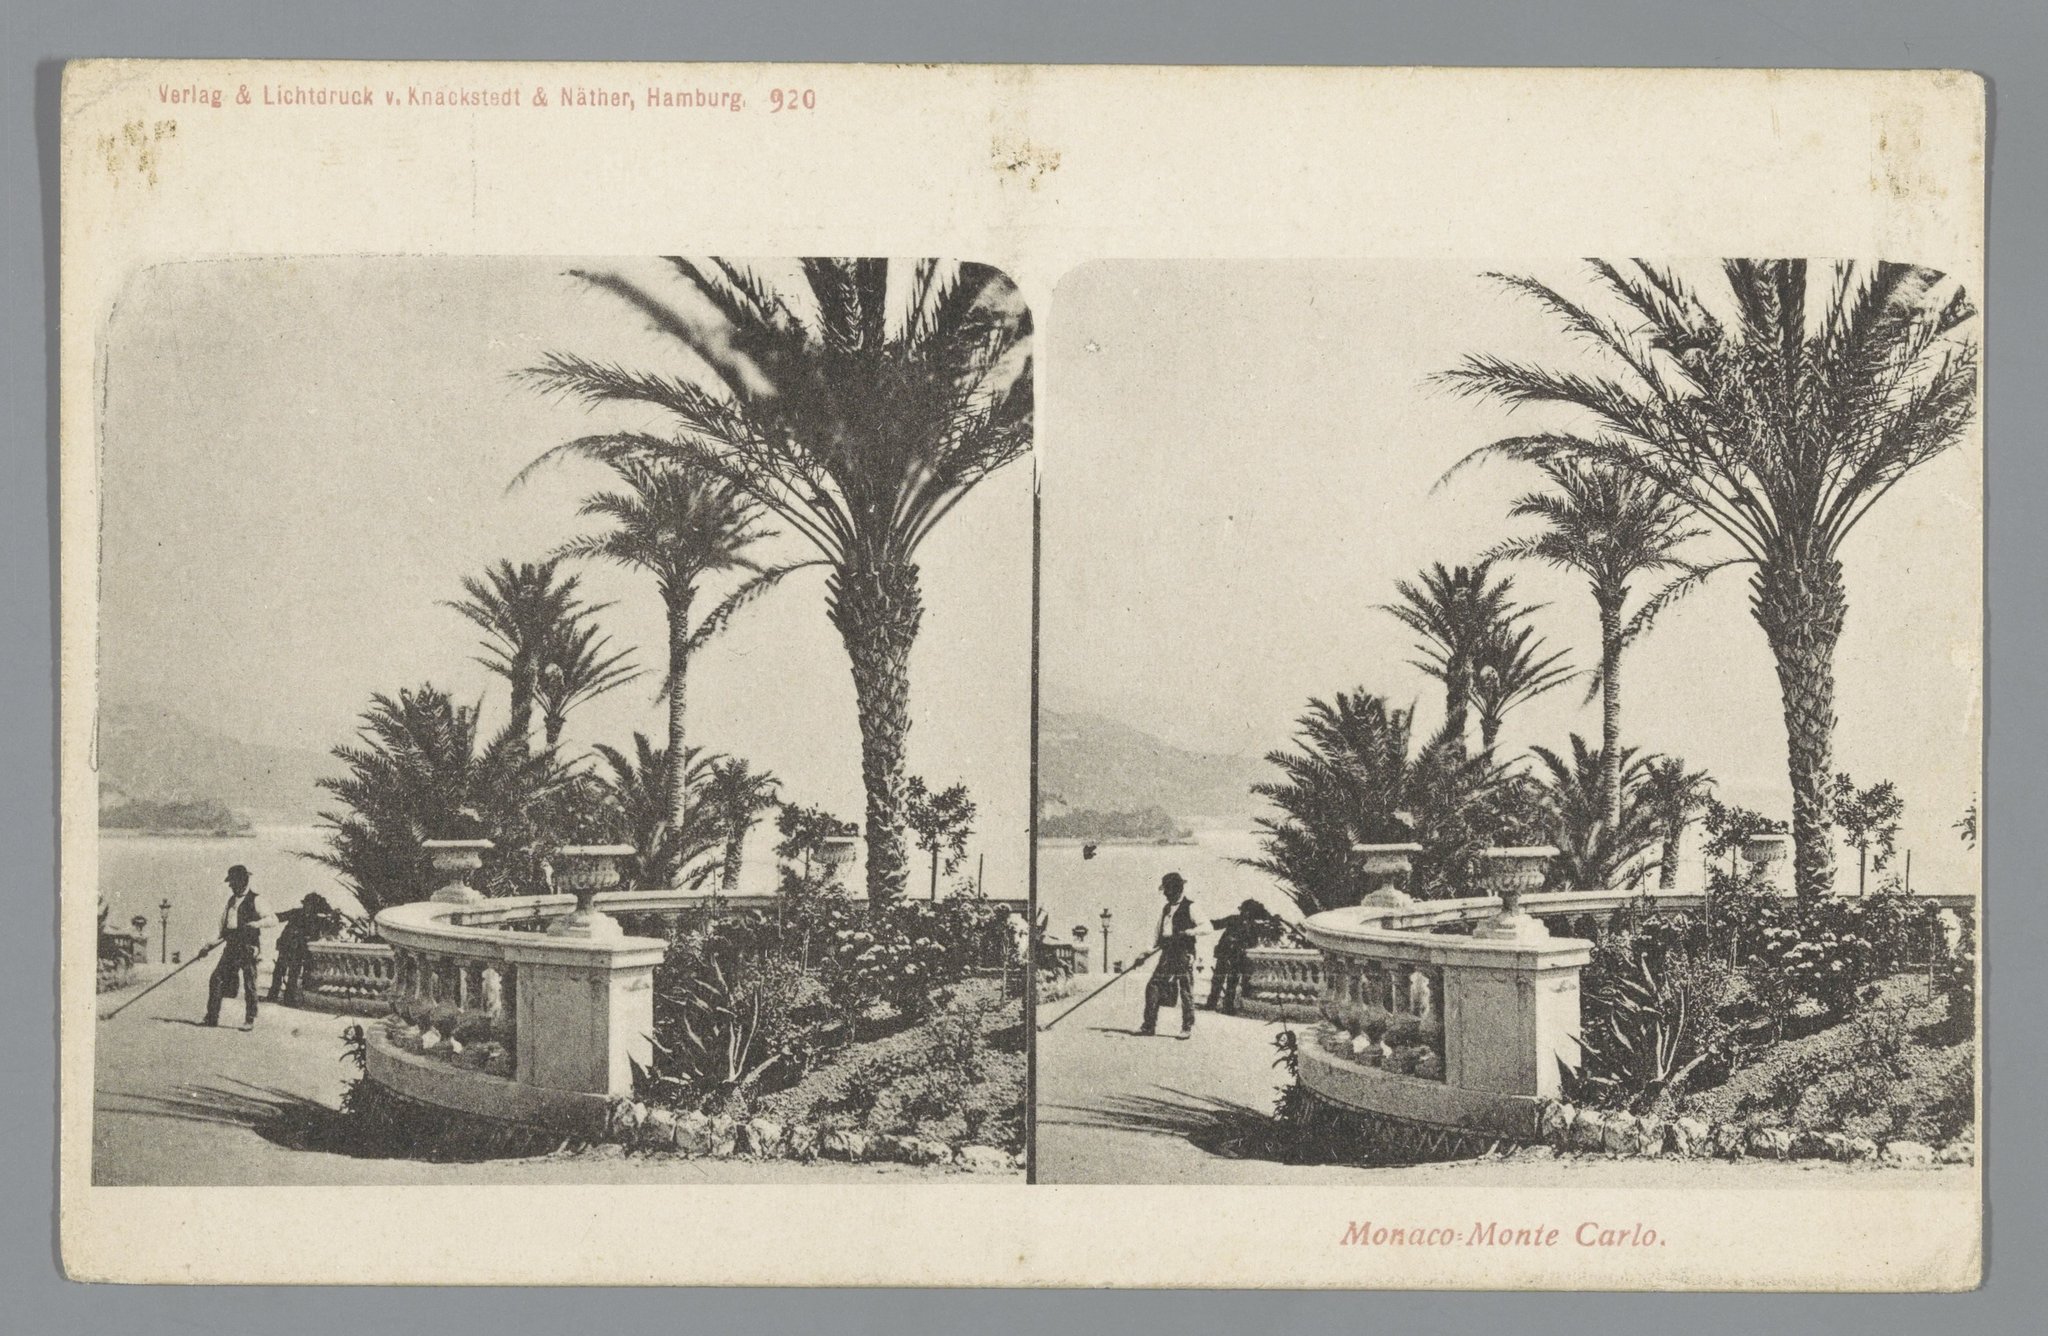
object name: ansichtkaart, prentbriefkaart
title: Monte Carlo te Monaco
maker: Anonymous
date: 1889-1905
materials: cardboard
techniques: photograph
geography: hamburg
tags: trees: palm-tree, avenue, boulevard, promenade, esplanade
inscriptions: number: ‘920’, inscription: ‘Briefkaart [...]’